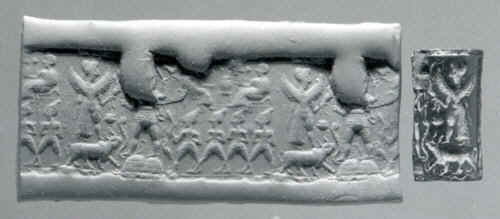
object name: cylinder seal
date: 1720-1650 BCE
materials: mineral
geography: syria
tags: animals